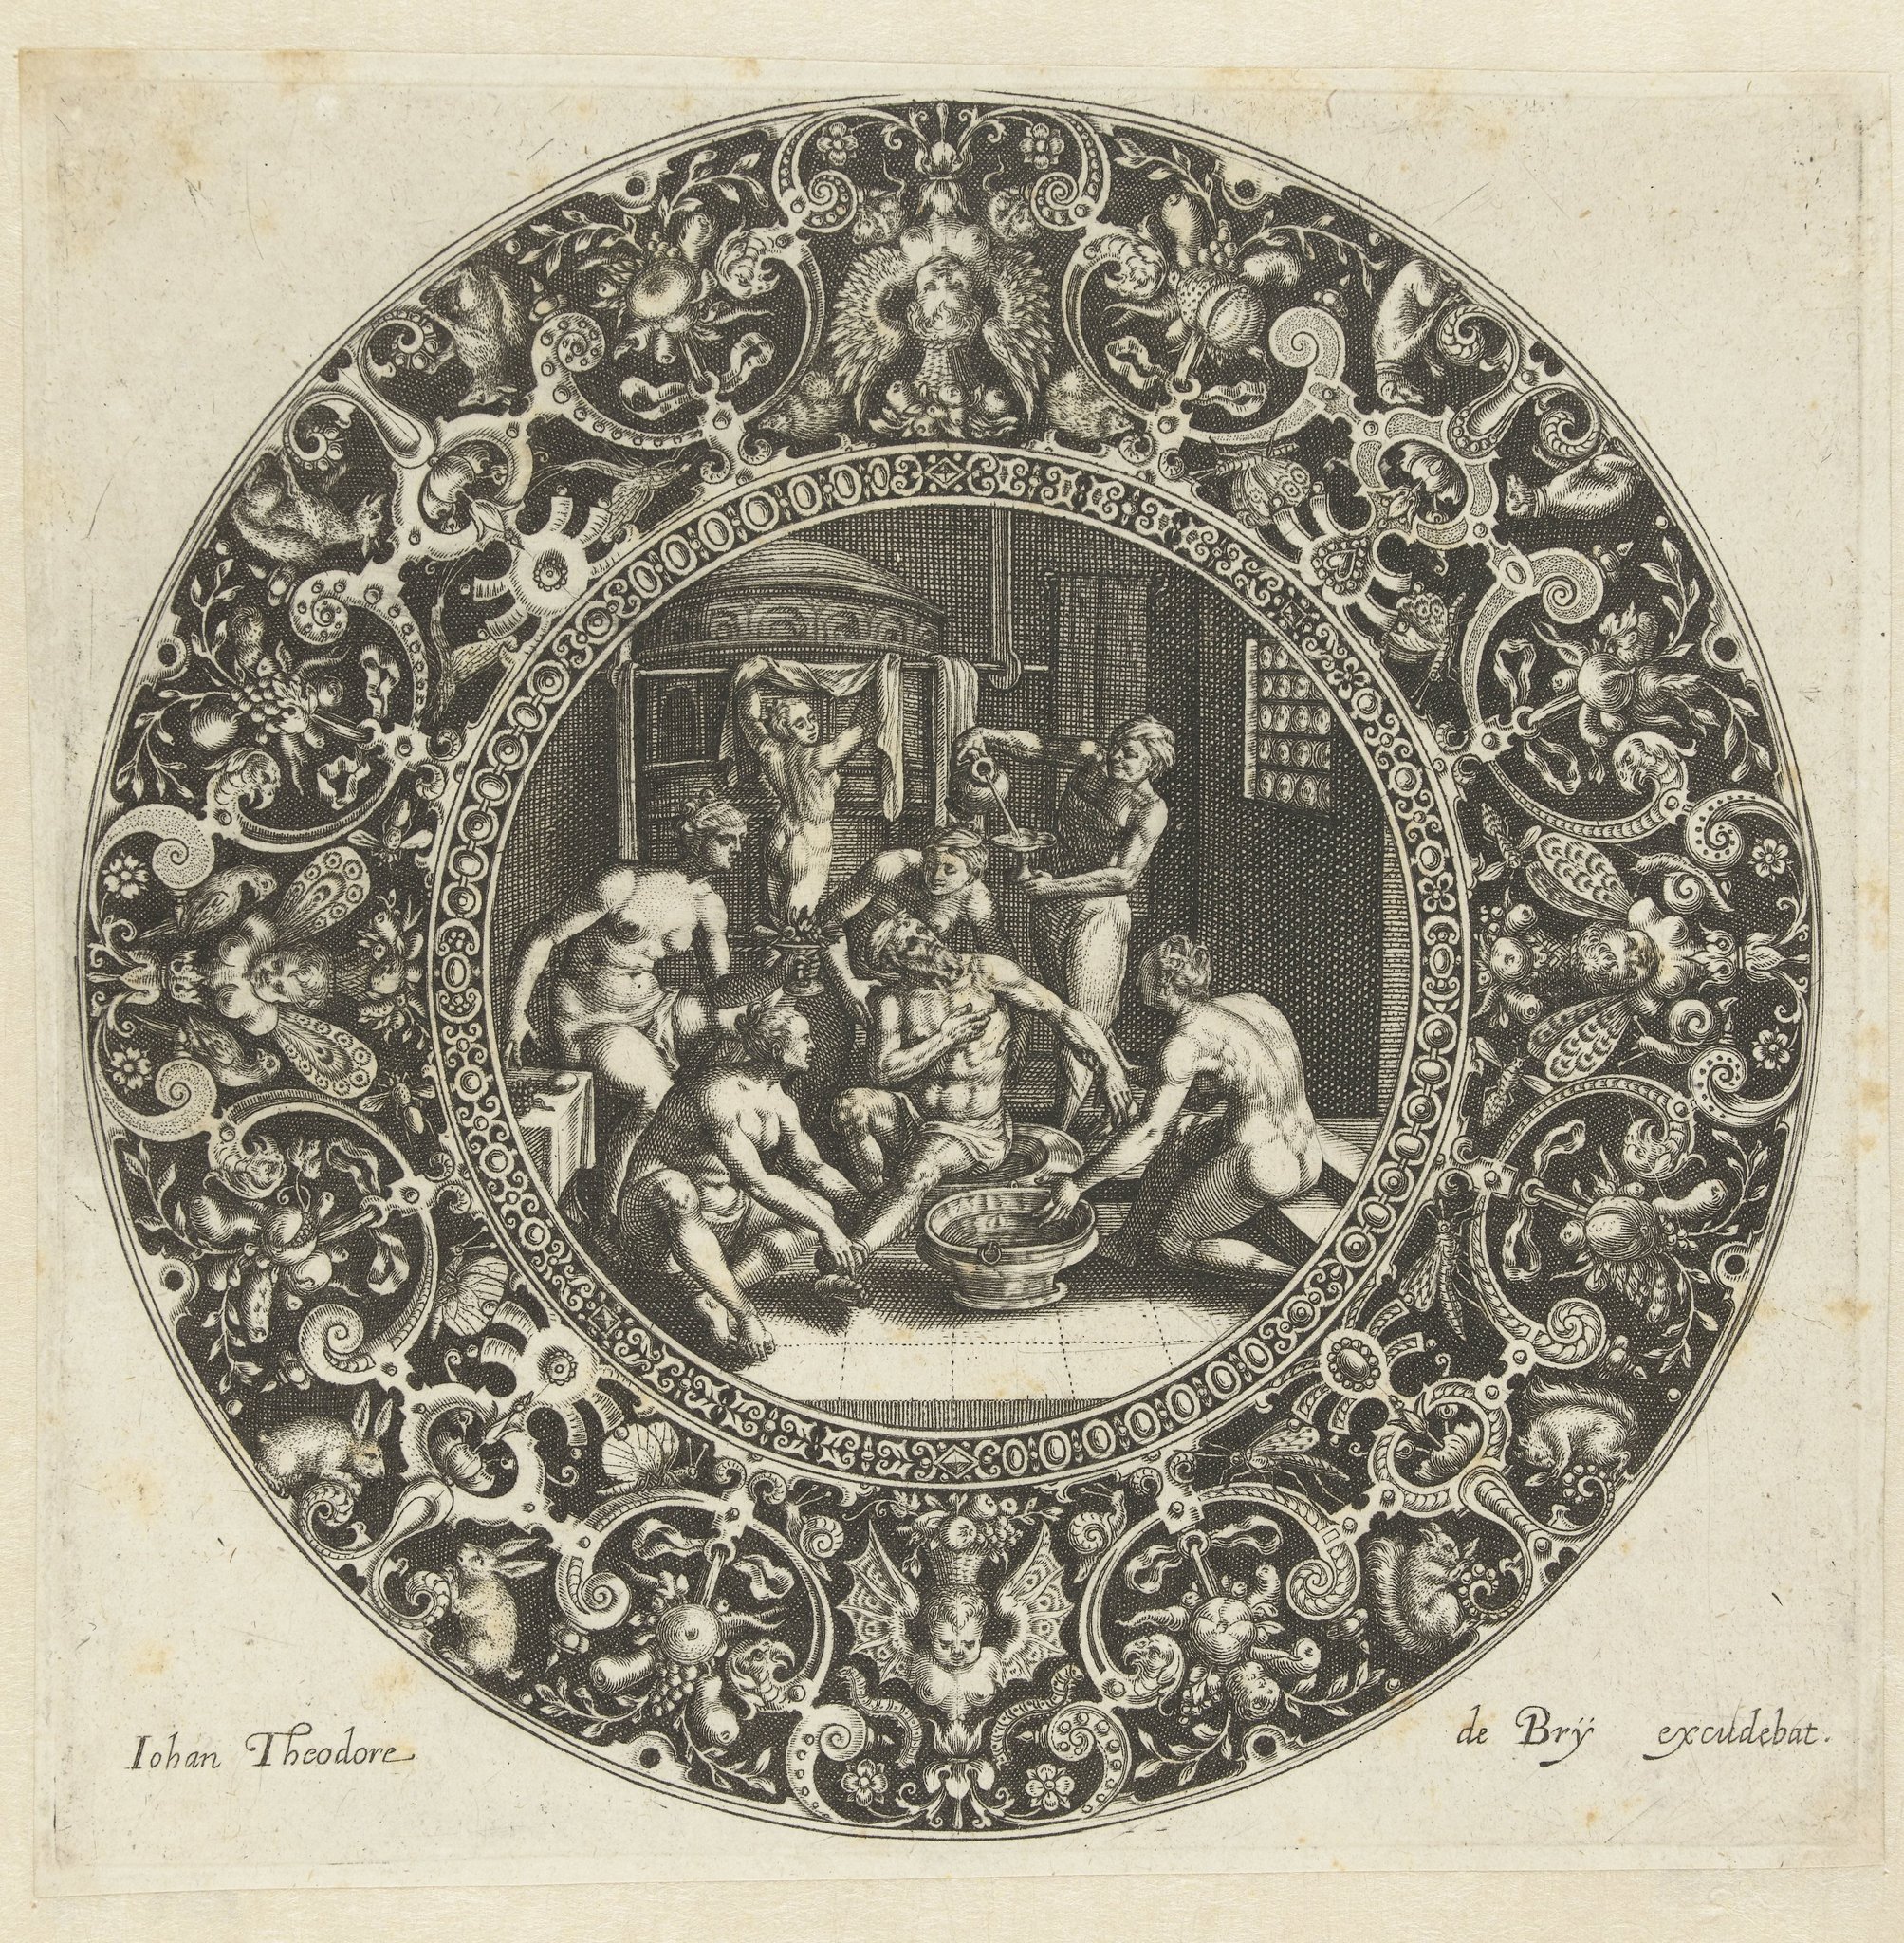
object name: ornament print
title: Heften van messen met grotesken op zwart fond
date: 1571-1623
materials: paper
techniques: engraving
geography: germany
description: In het midden van de schotel Sardanapalus in bad, omringd door dienaressen.